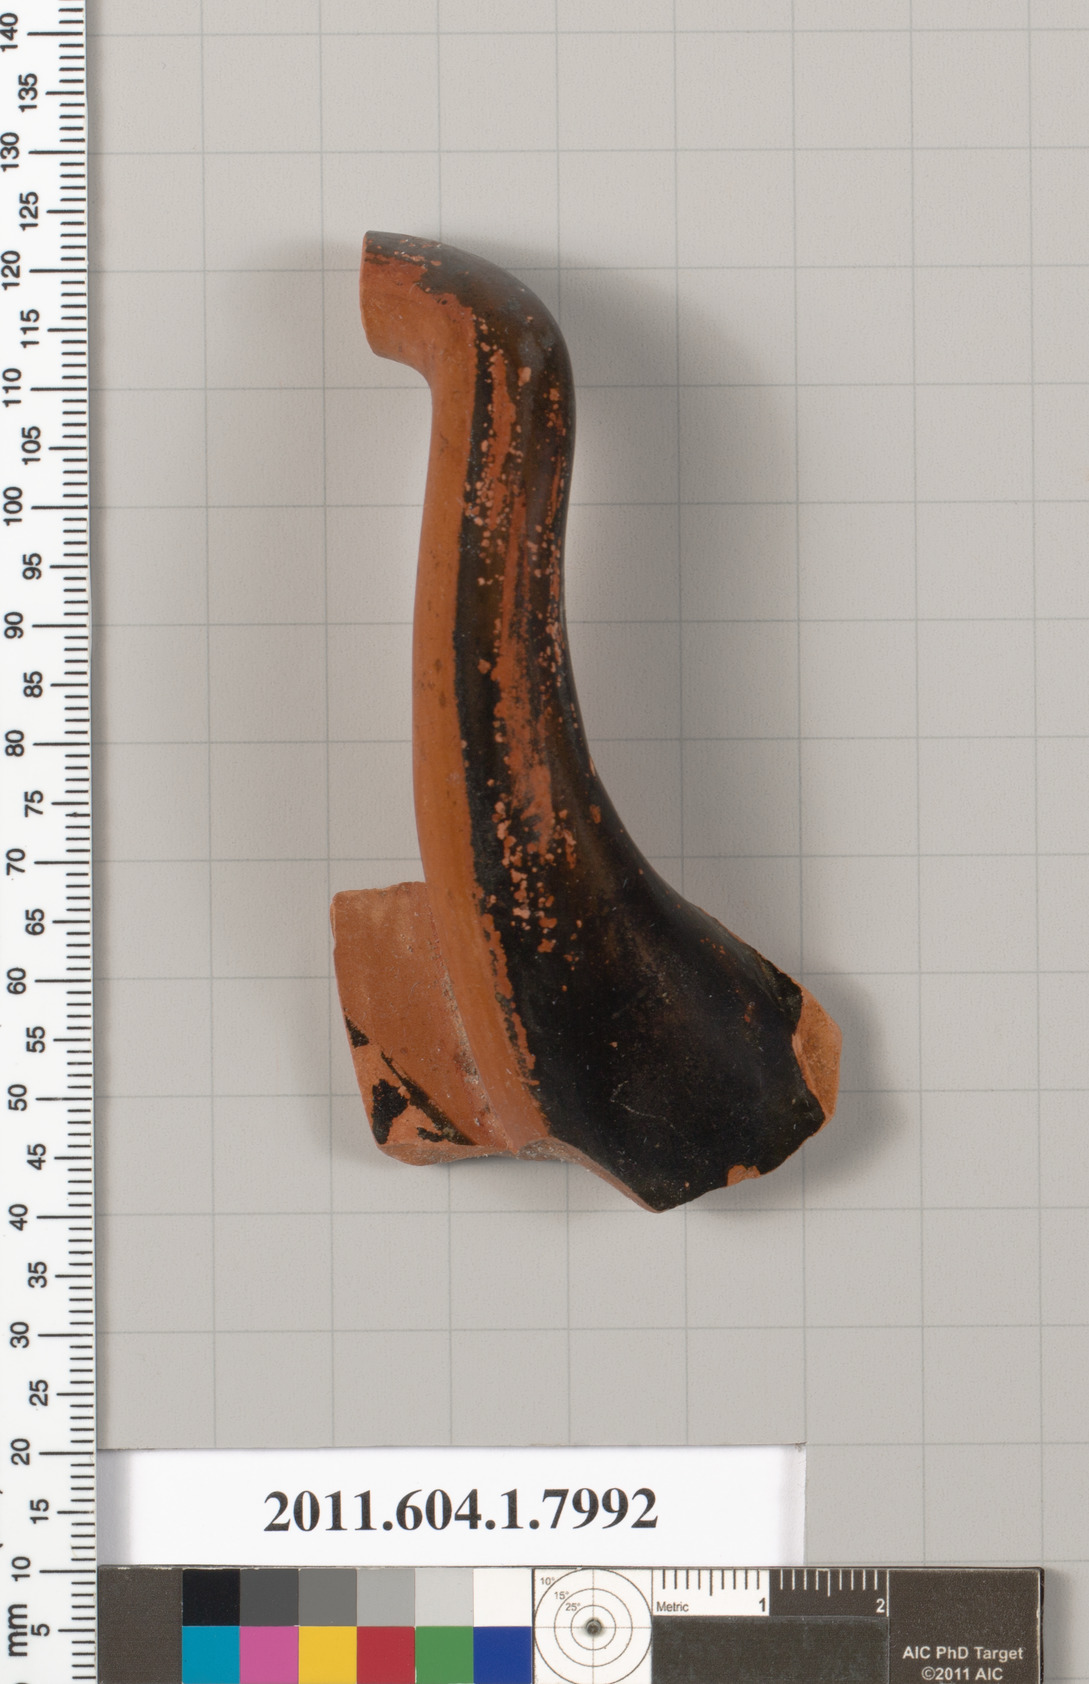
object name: kylix fragment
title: Terracotta fragment of a kylix (drinking cup)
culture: greek, attic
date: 460-450 BCE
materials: terracotta